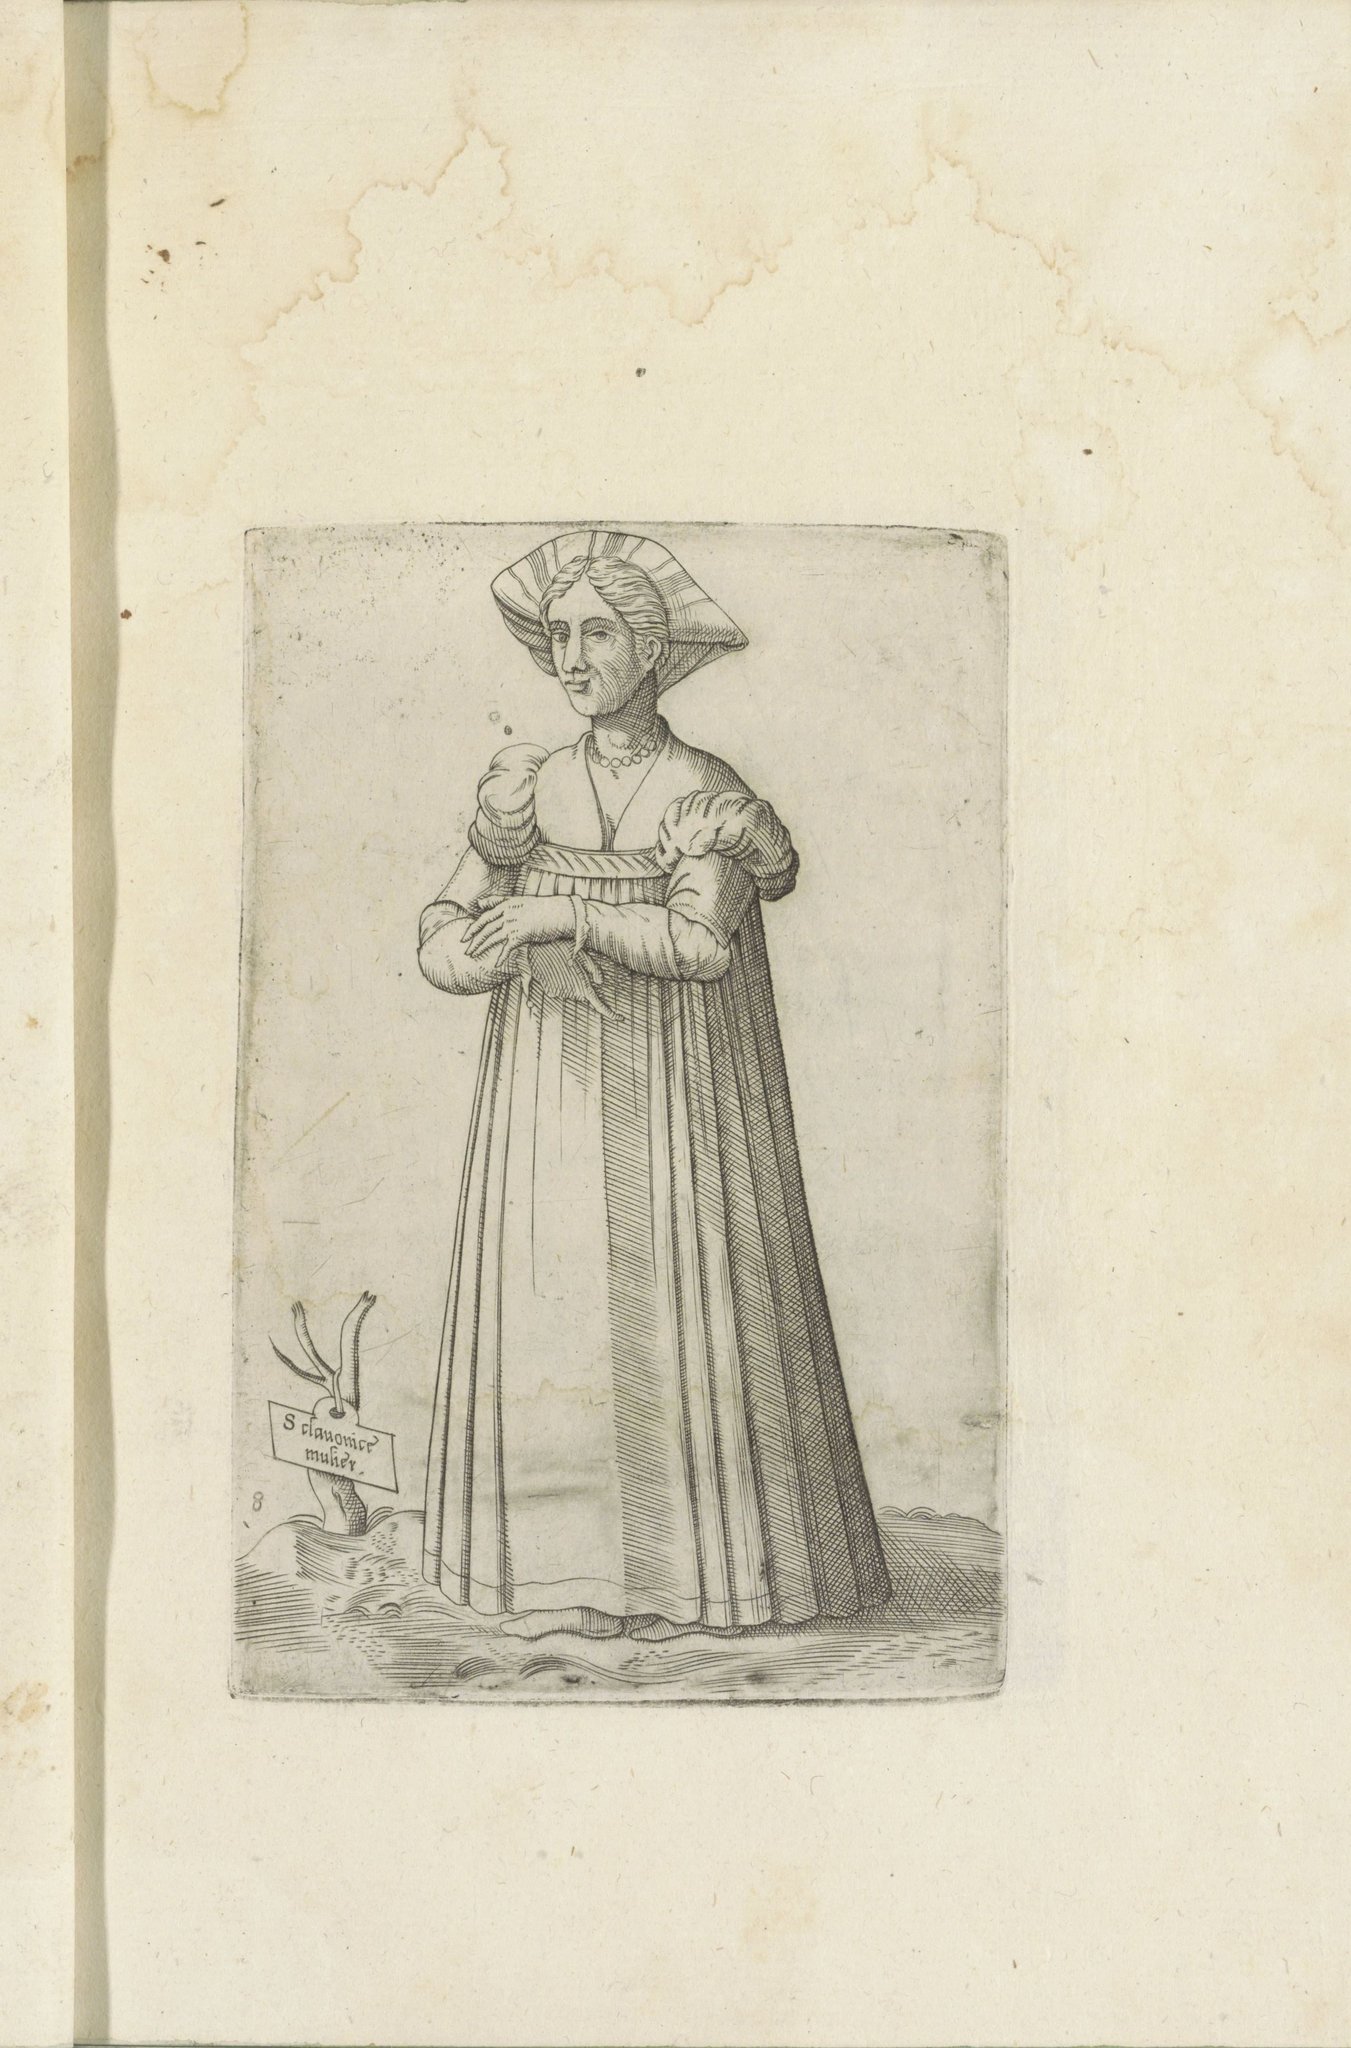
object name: costume print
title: Staande vrouw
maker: ferando bertelli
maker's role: print maker, publisher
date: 1569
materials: paper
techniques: engraving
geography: venice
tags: fashion plates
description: Staande vrouw. Onderdeel van het kostuumboek getiteld 'Omnium fere gentium nostrae aetatis habitus, nunquam ante hac aediti', Venetië 1569. Heruitgave uit 1569 van de eerste editie uit 1563.